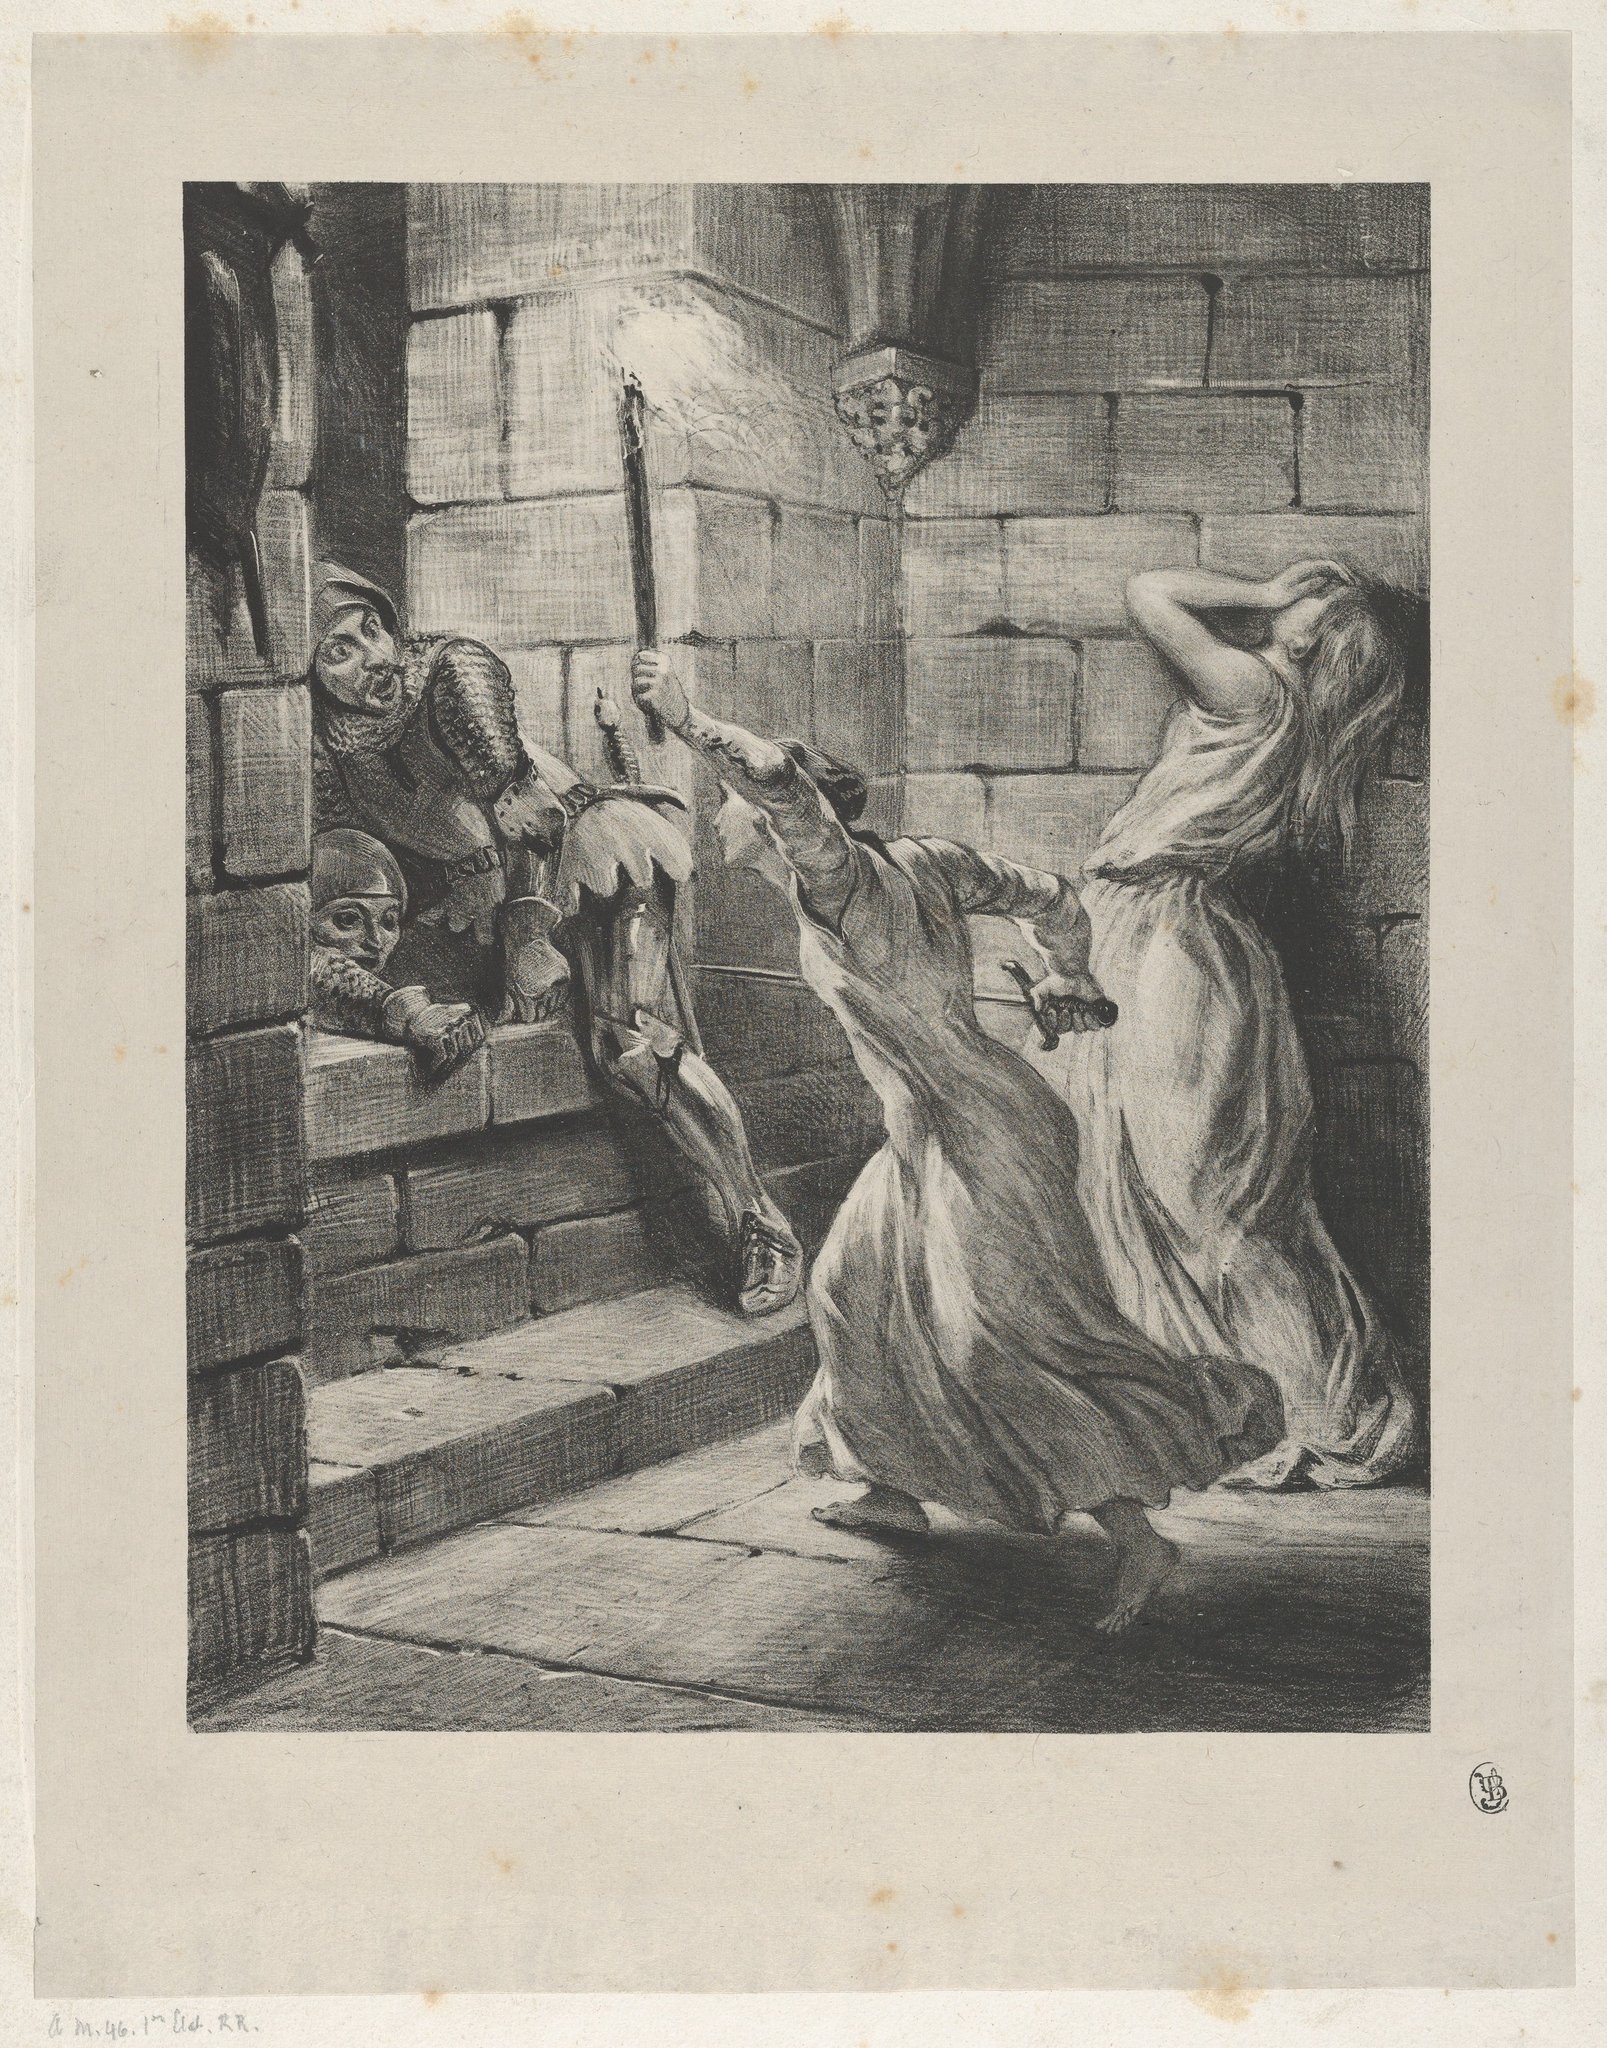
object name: print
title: The Sister of Duguesclin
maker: eugène delacroix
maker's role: artist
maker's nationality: french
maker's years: 1798-1863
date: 1829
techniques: printmaking, lithograph, wash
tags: soldiers,swords,men,women